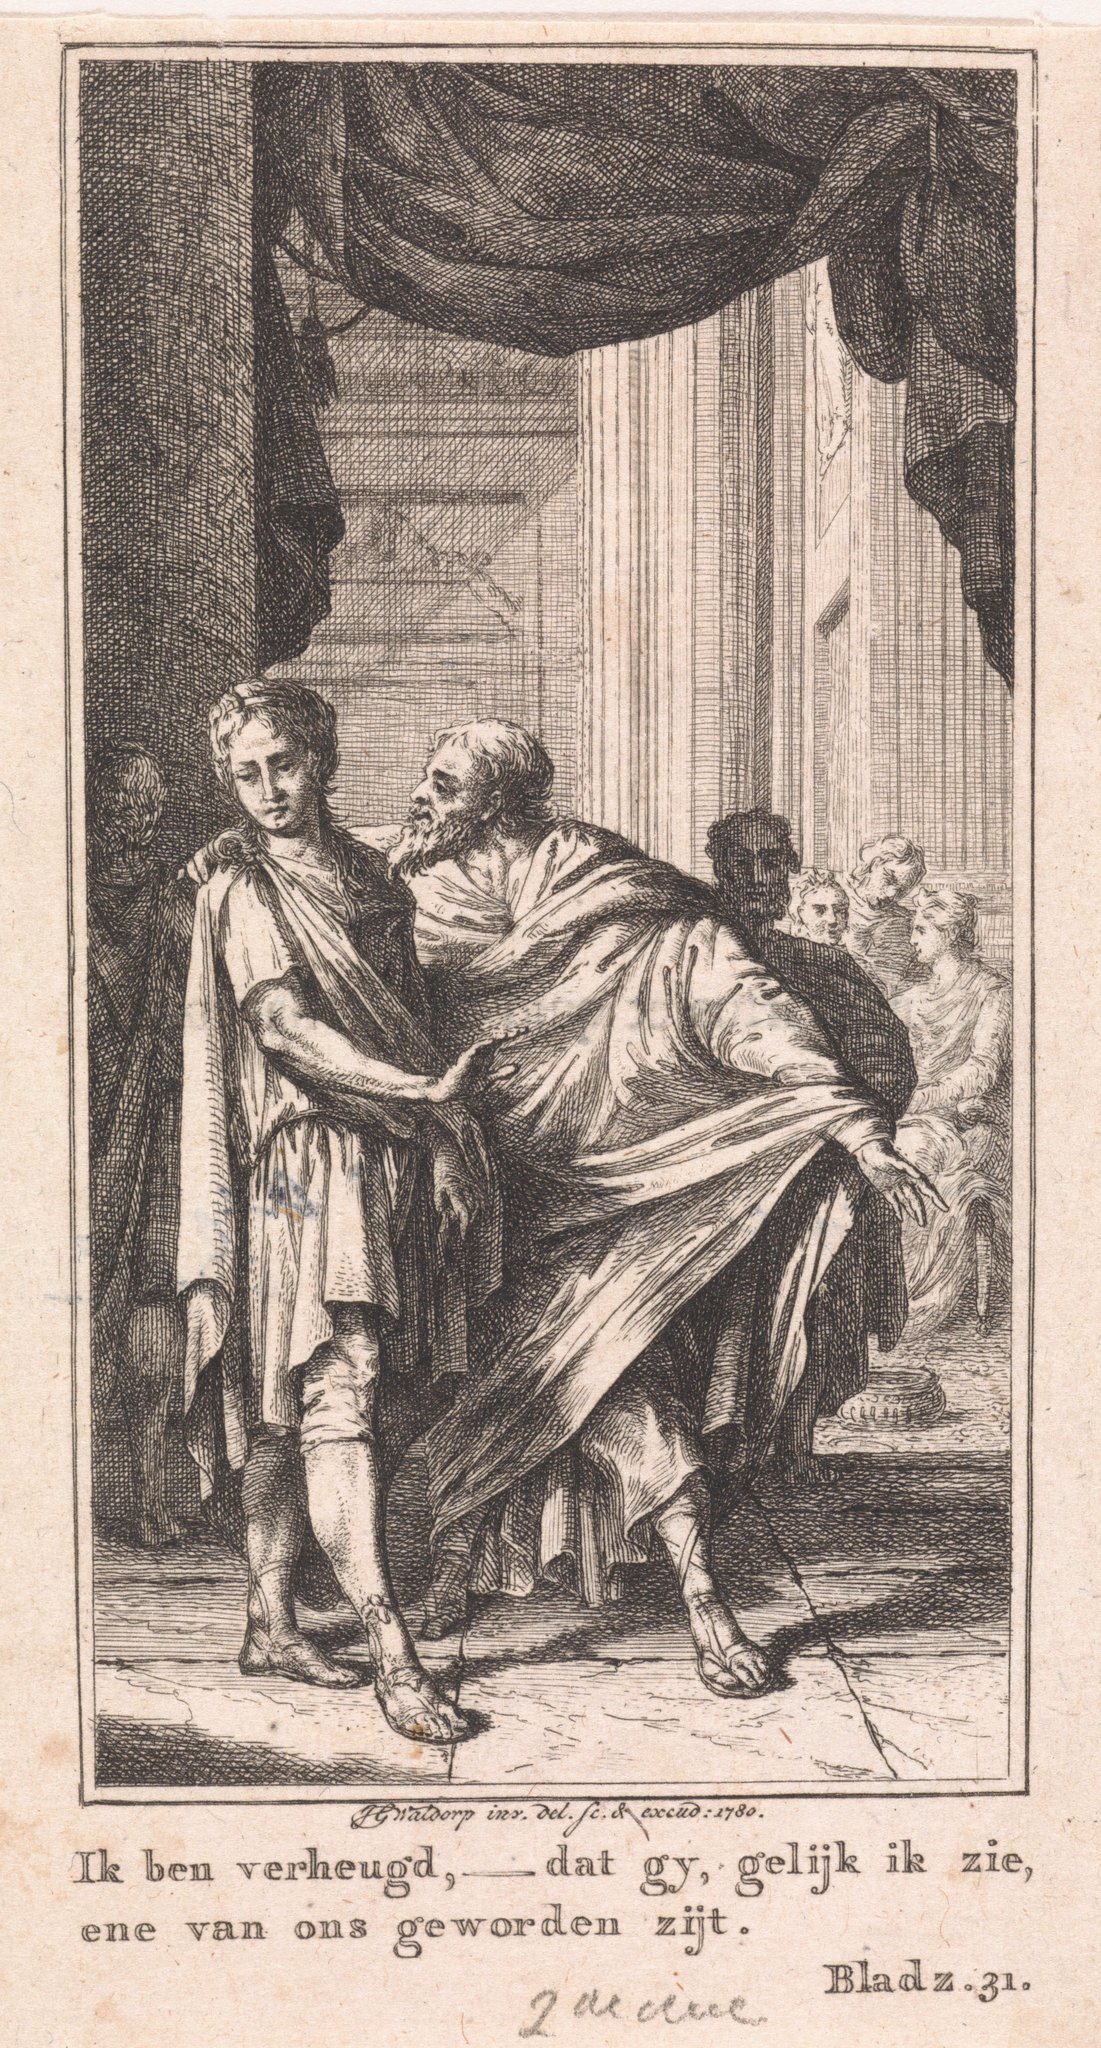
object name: book illustration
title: Oude man omarmt een jonge man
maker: jan gerard waldorp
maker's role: draughtsman, print maker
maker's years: 1740-1808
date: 1780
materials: paper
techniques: engraving, etching, letterpress printing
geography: amsterdam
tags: specific works of literature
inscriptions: inscription: ‘Quid Virtus et quid Sapientia possit.’, collector's mark: Lugt 2228, inscription: ‘Uit het 2de deel’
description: Een oude man heeft zijn arm om een jonge man geslagen en leidt hem richting een gezelschap. De jonge man maakt een afwerend gebaar. Onder de voorstelling een citaat van twee regels in het Nederlands uit het boek.